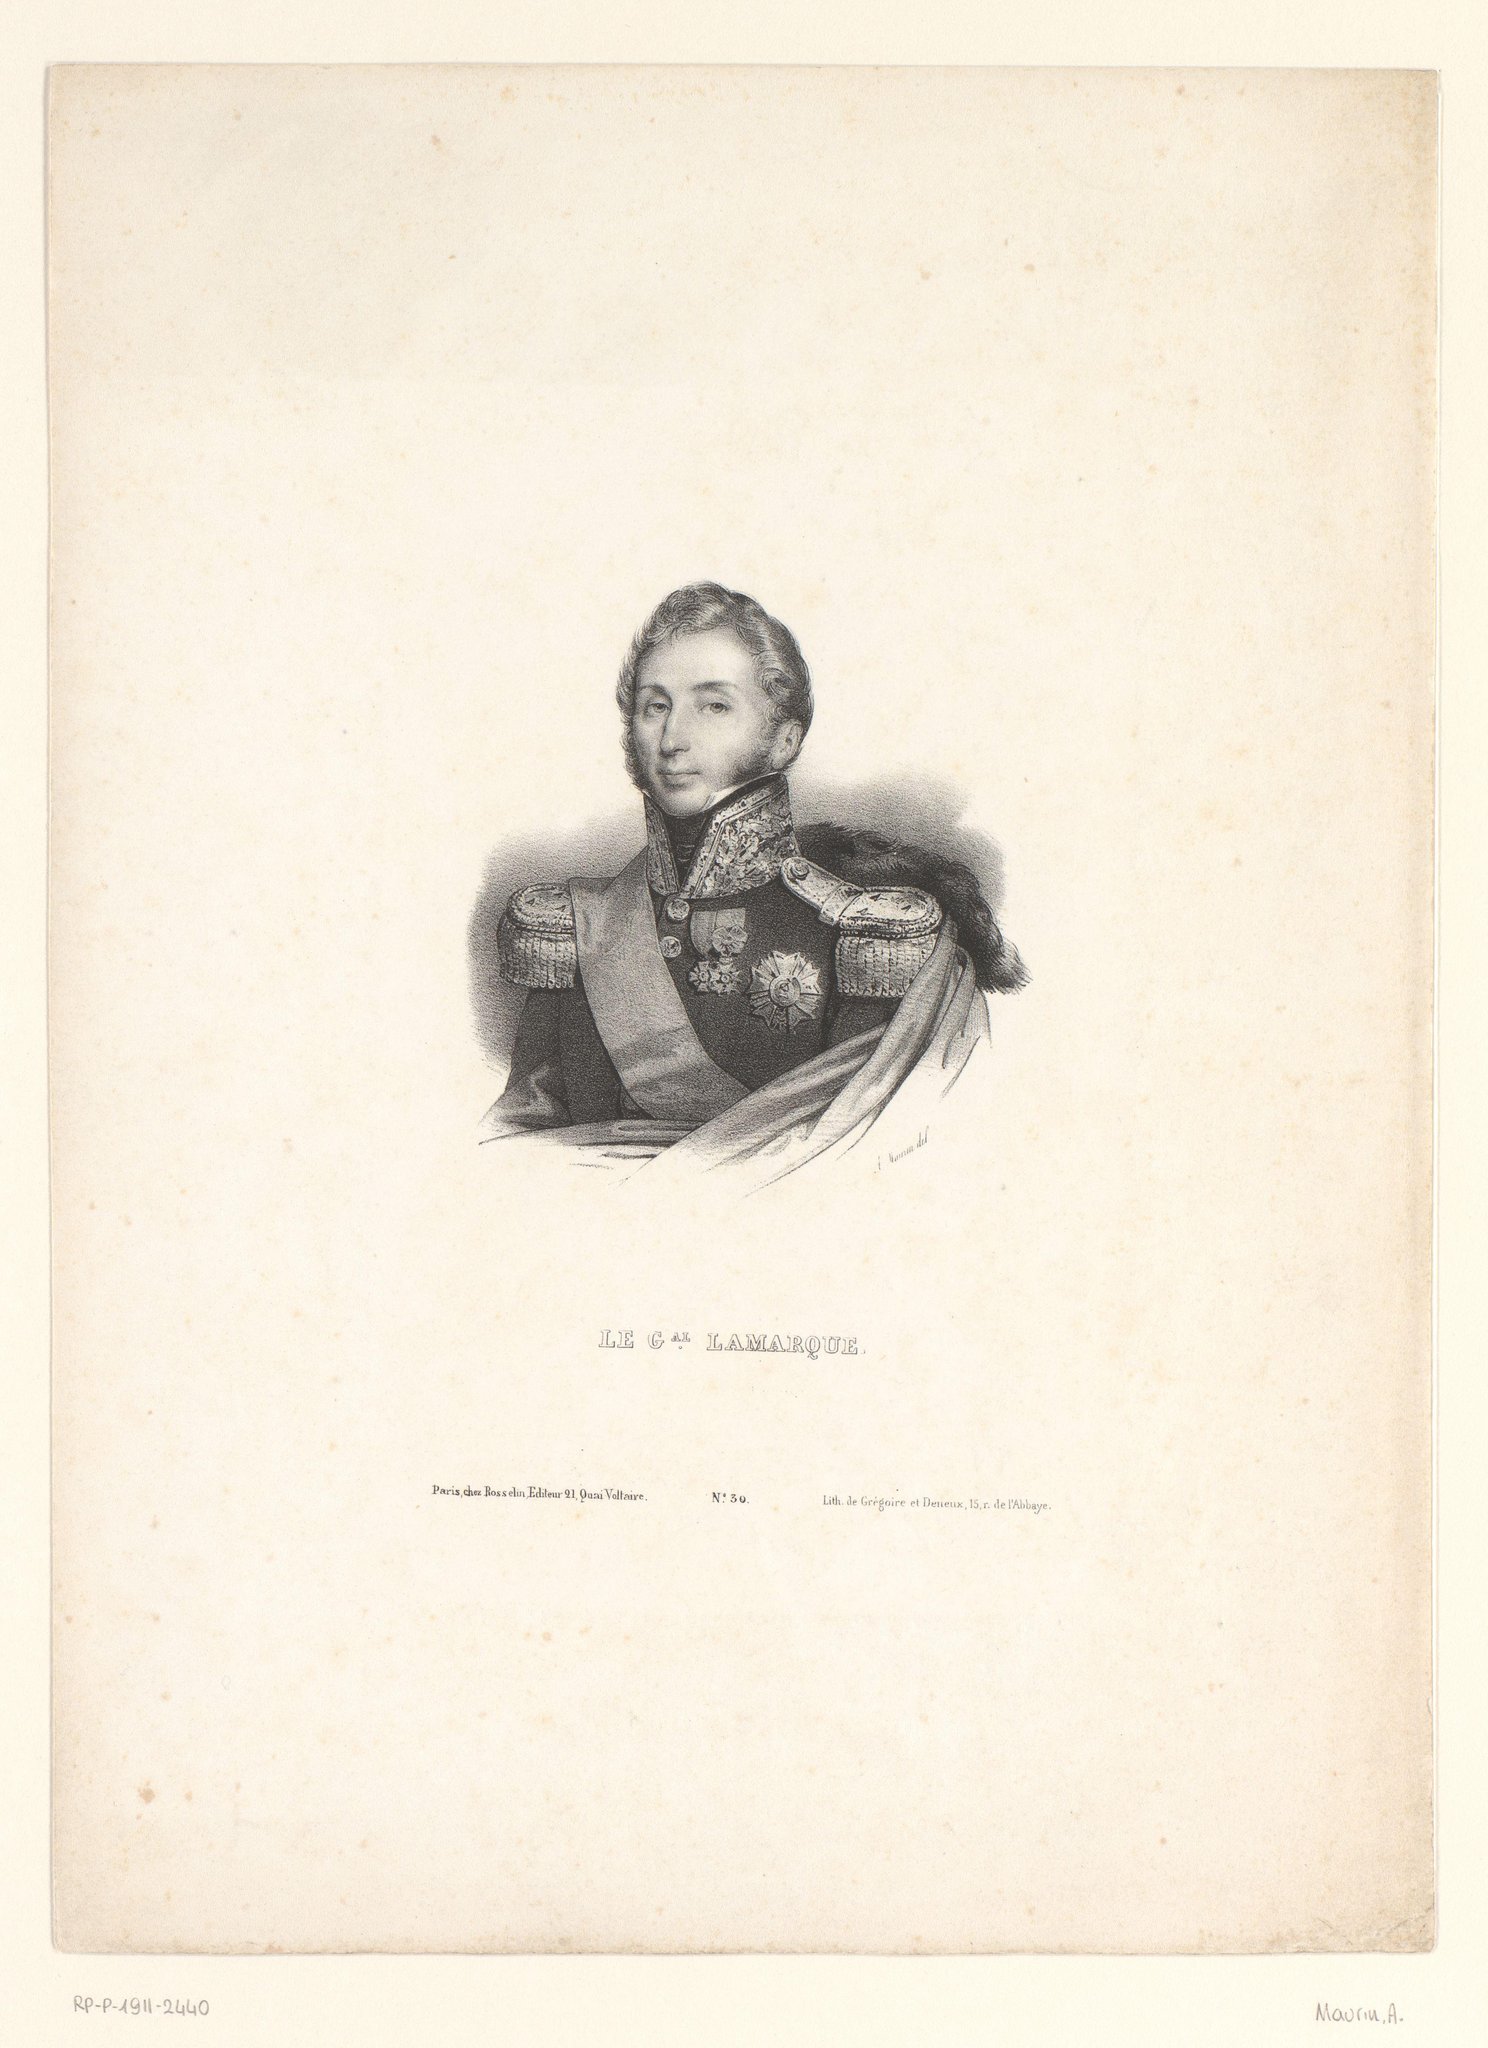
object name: print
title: Portret van Jean Maximilien Lamarque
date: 1832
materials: paper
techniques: lithograph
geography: paris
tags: paris, politician, historical persons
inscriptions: collector's mark: Lugt 2228